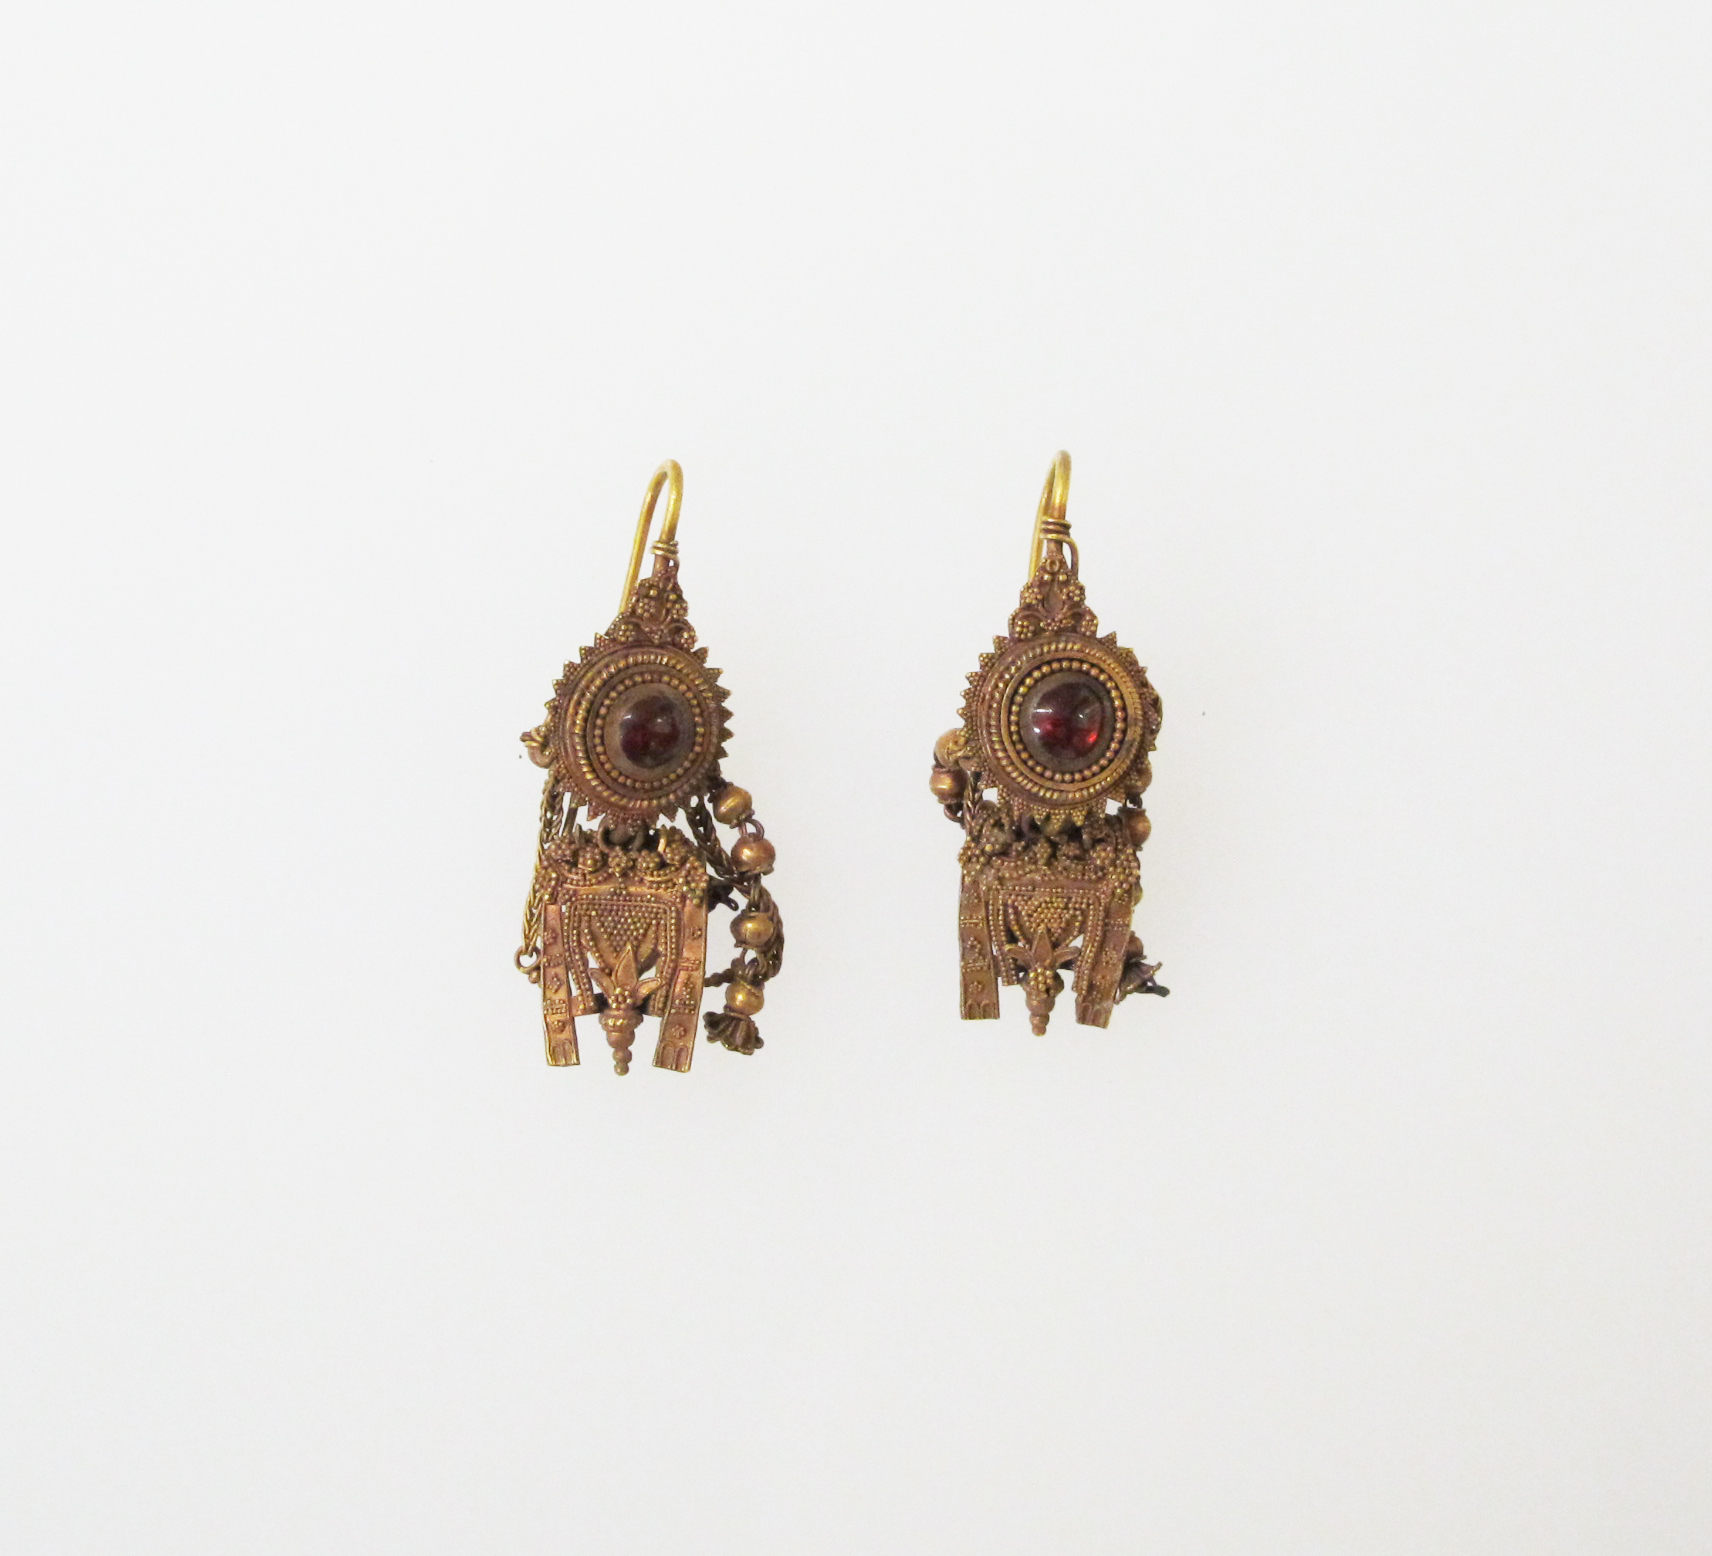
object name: earring with pendant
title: Earring with pendant and chains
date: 7000 BCE-330 CE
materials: gemstone, gold